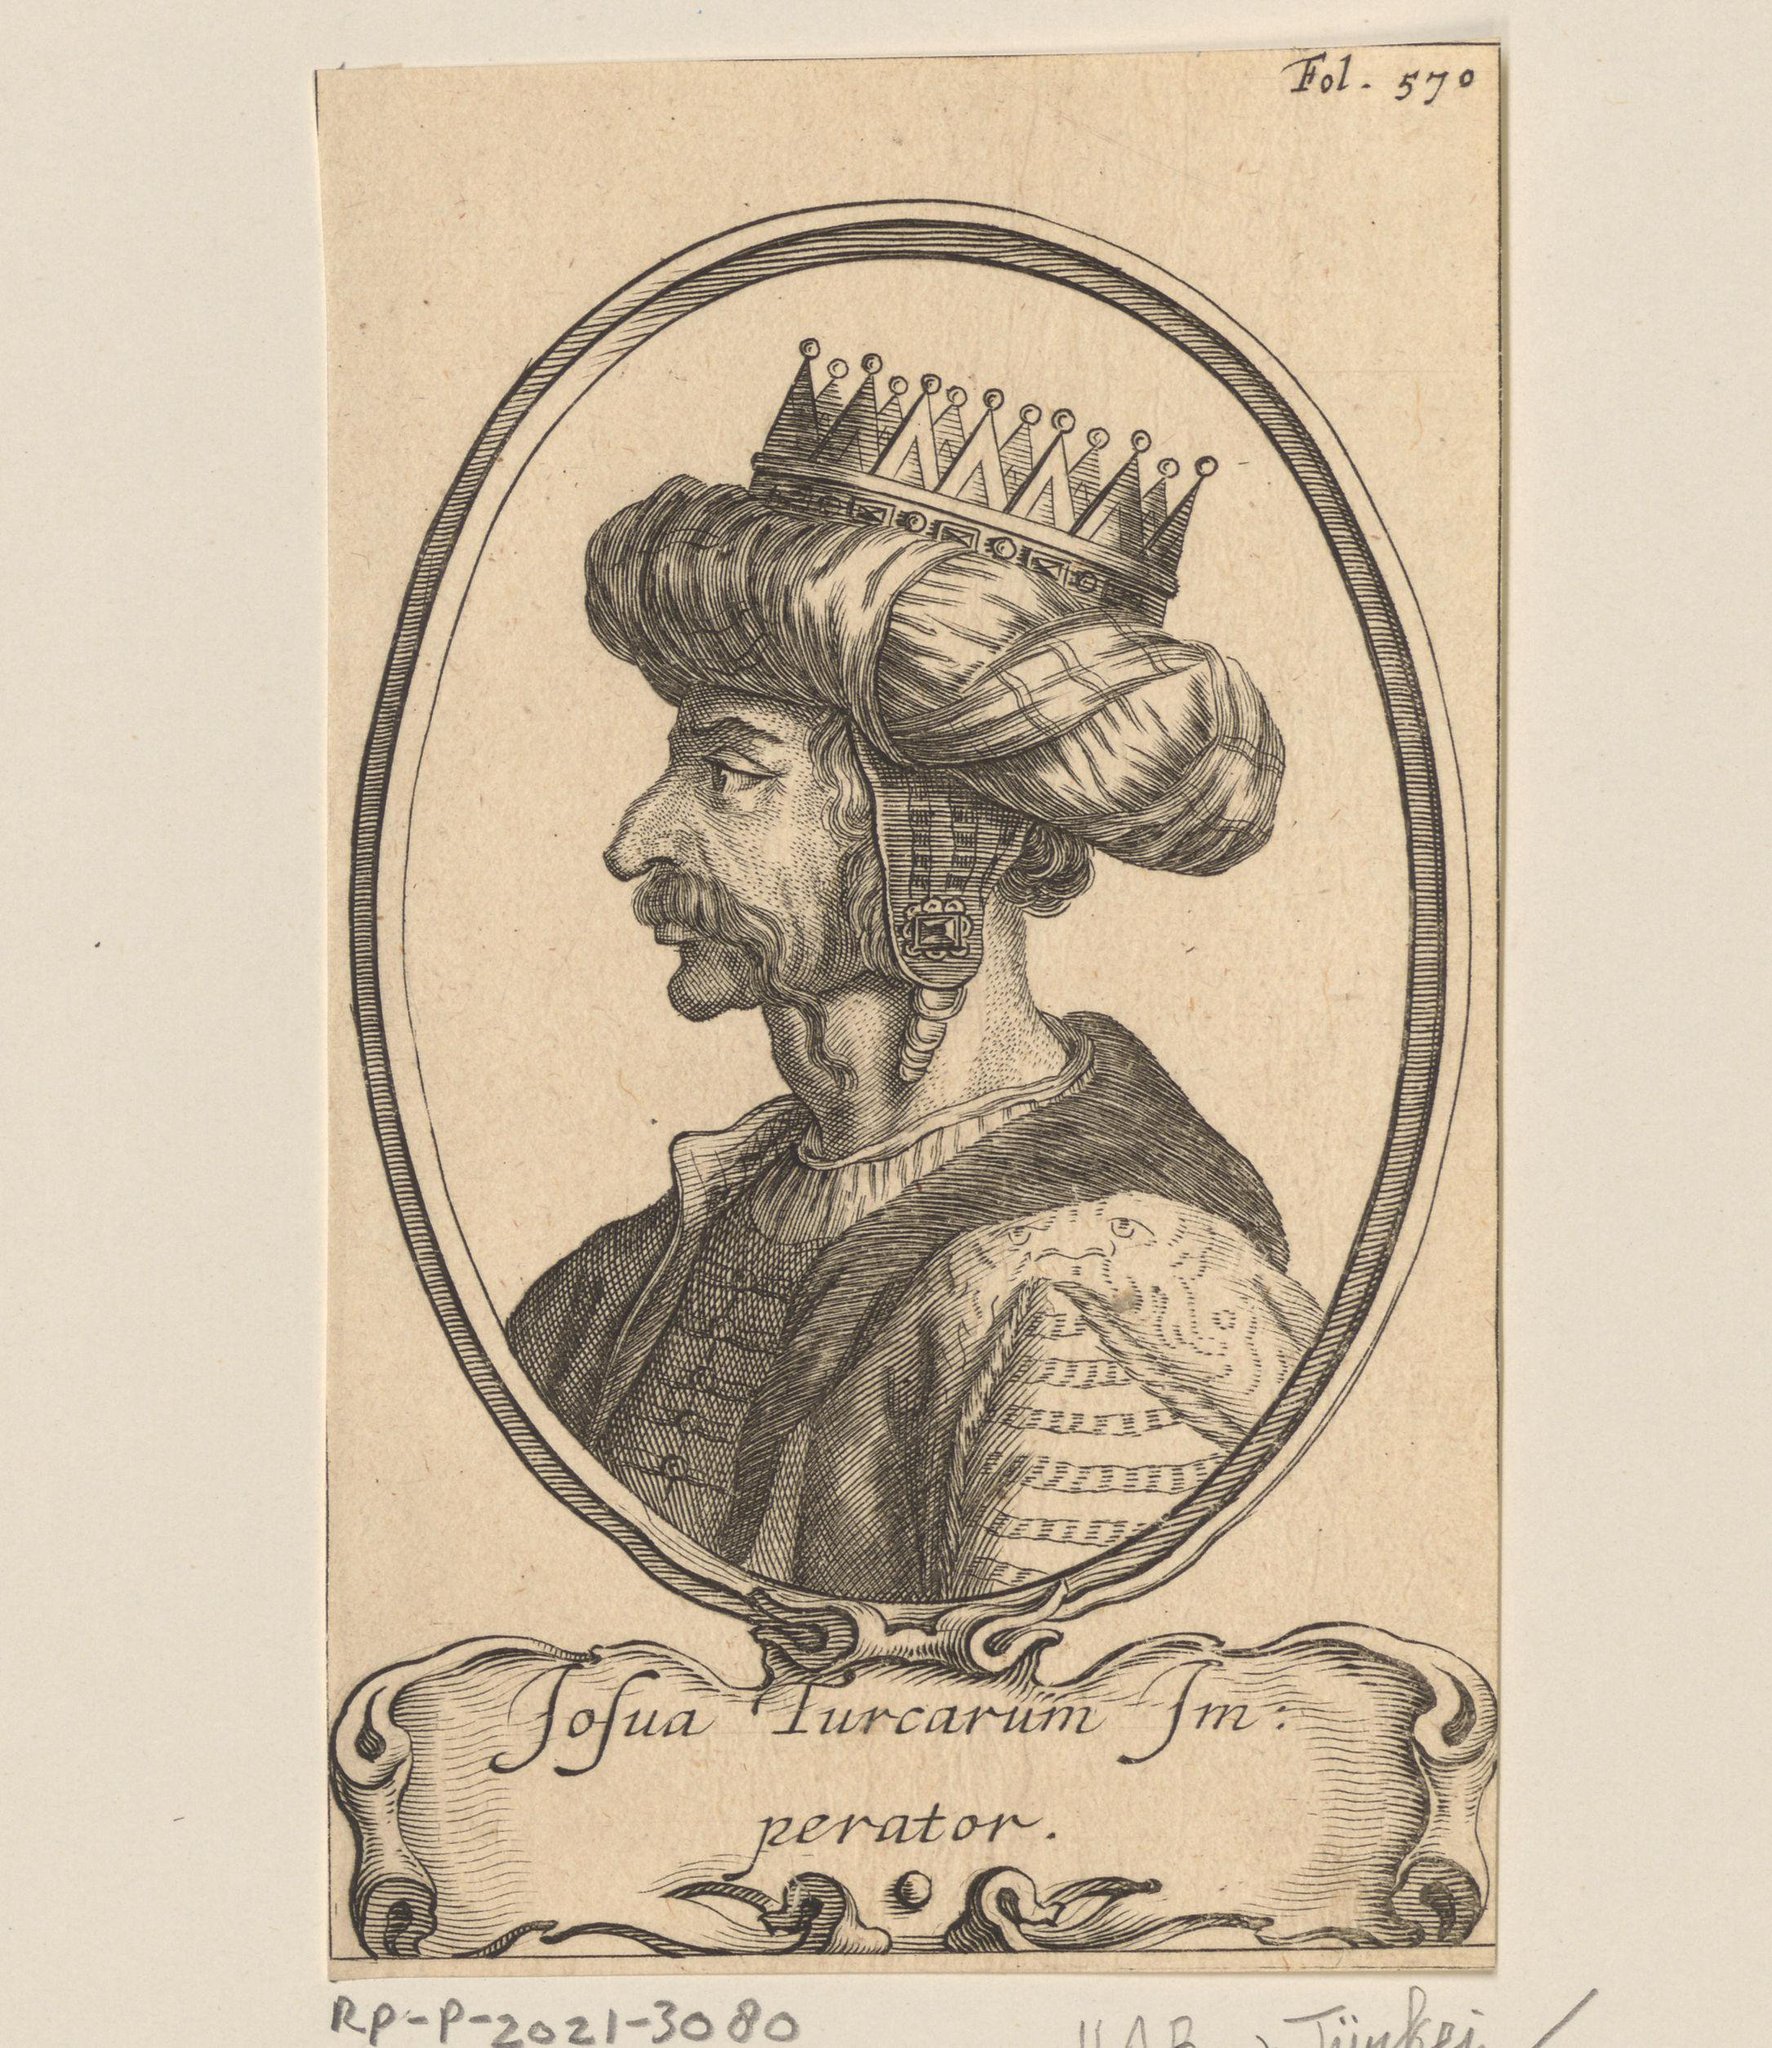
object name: print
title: Portret van İsa Çelebi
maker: Anonymous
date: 1656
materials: paper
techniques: engraving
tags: prince, historical persons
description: Prent waarschijnlijk uit: Bos, Lambert van den. Het konincklyk treur-toonneel, ofte op- en ondergangh der keyseren, koningen en vorsten (...). Dordrecht: Jacobus Savry, 1656, dl. 1, fol. 570.